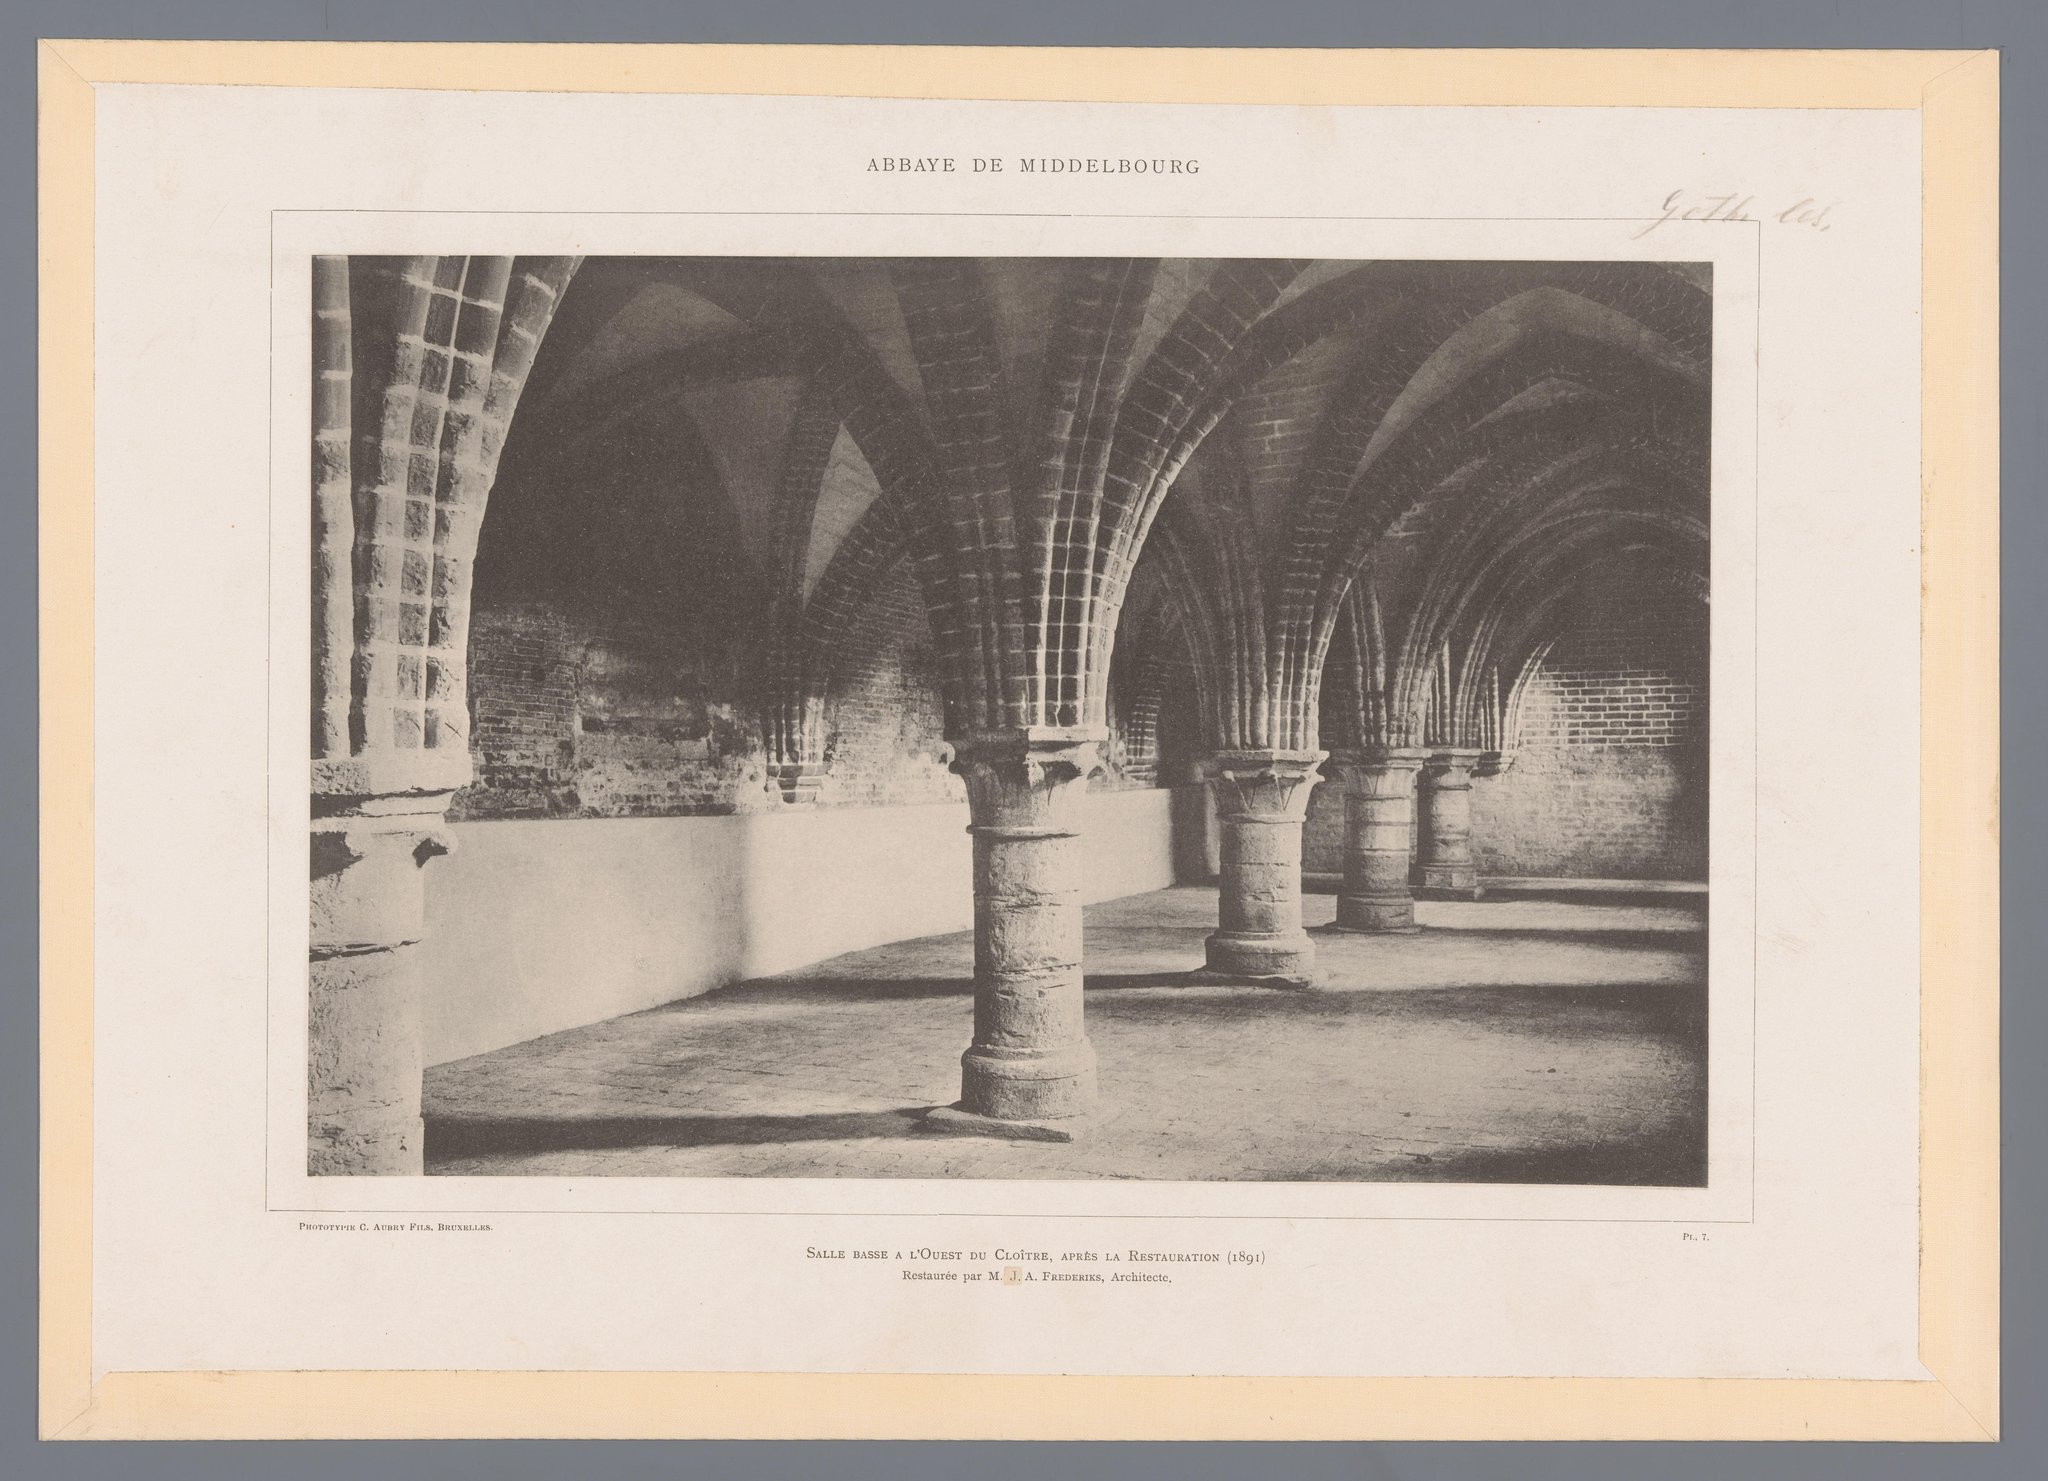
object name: photomechanical print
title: Interieur van het oostelijke deel van het klooster van de Abdij van Middelburg voor de restauratie, 1891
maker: Anonymous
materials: paper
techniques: photograph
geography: brussels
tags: abbey, monastery, convent ~ roman catholic church, interior ~ representation of a building